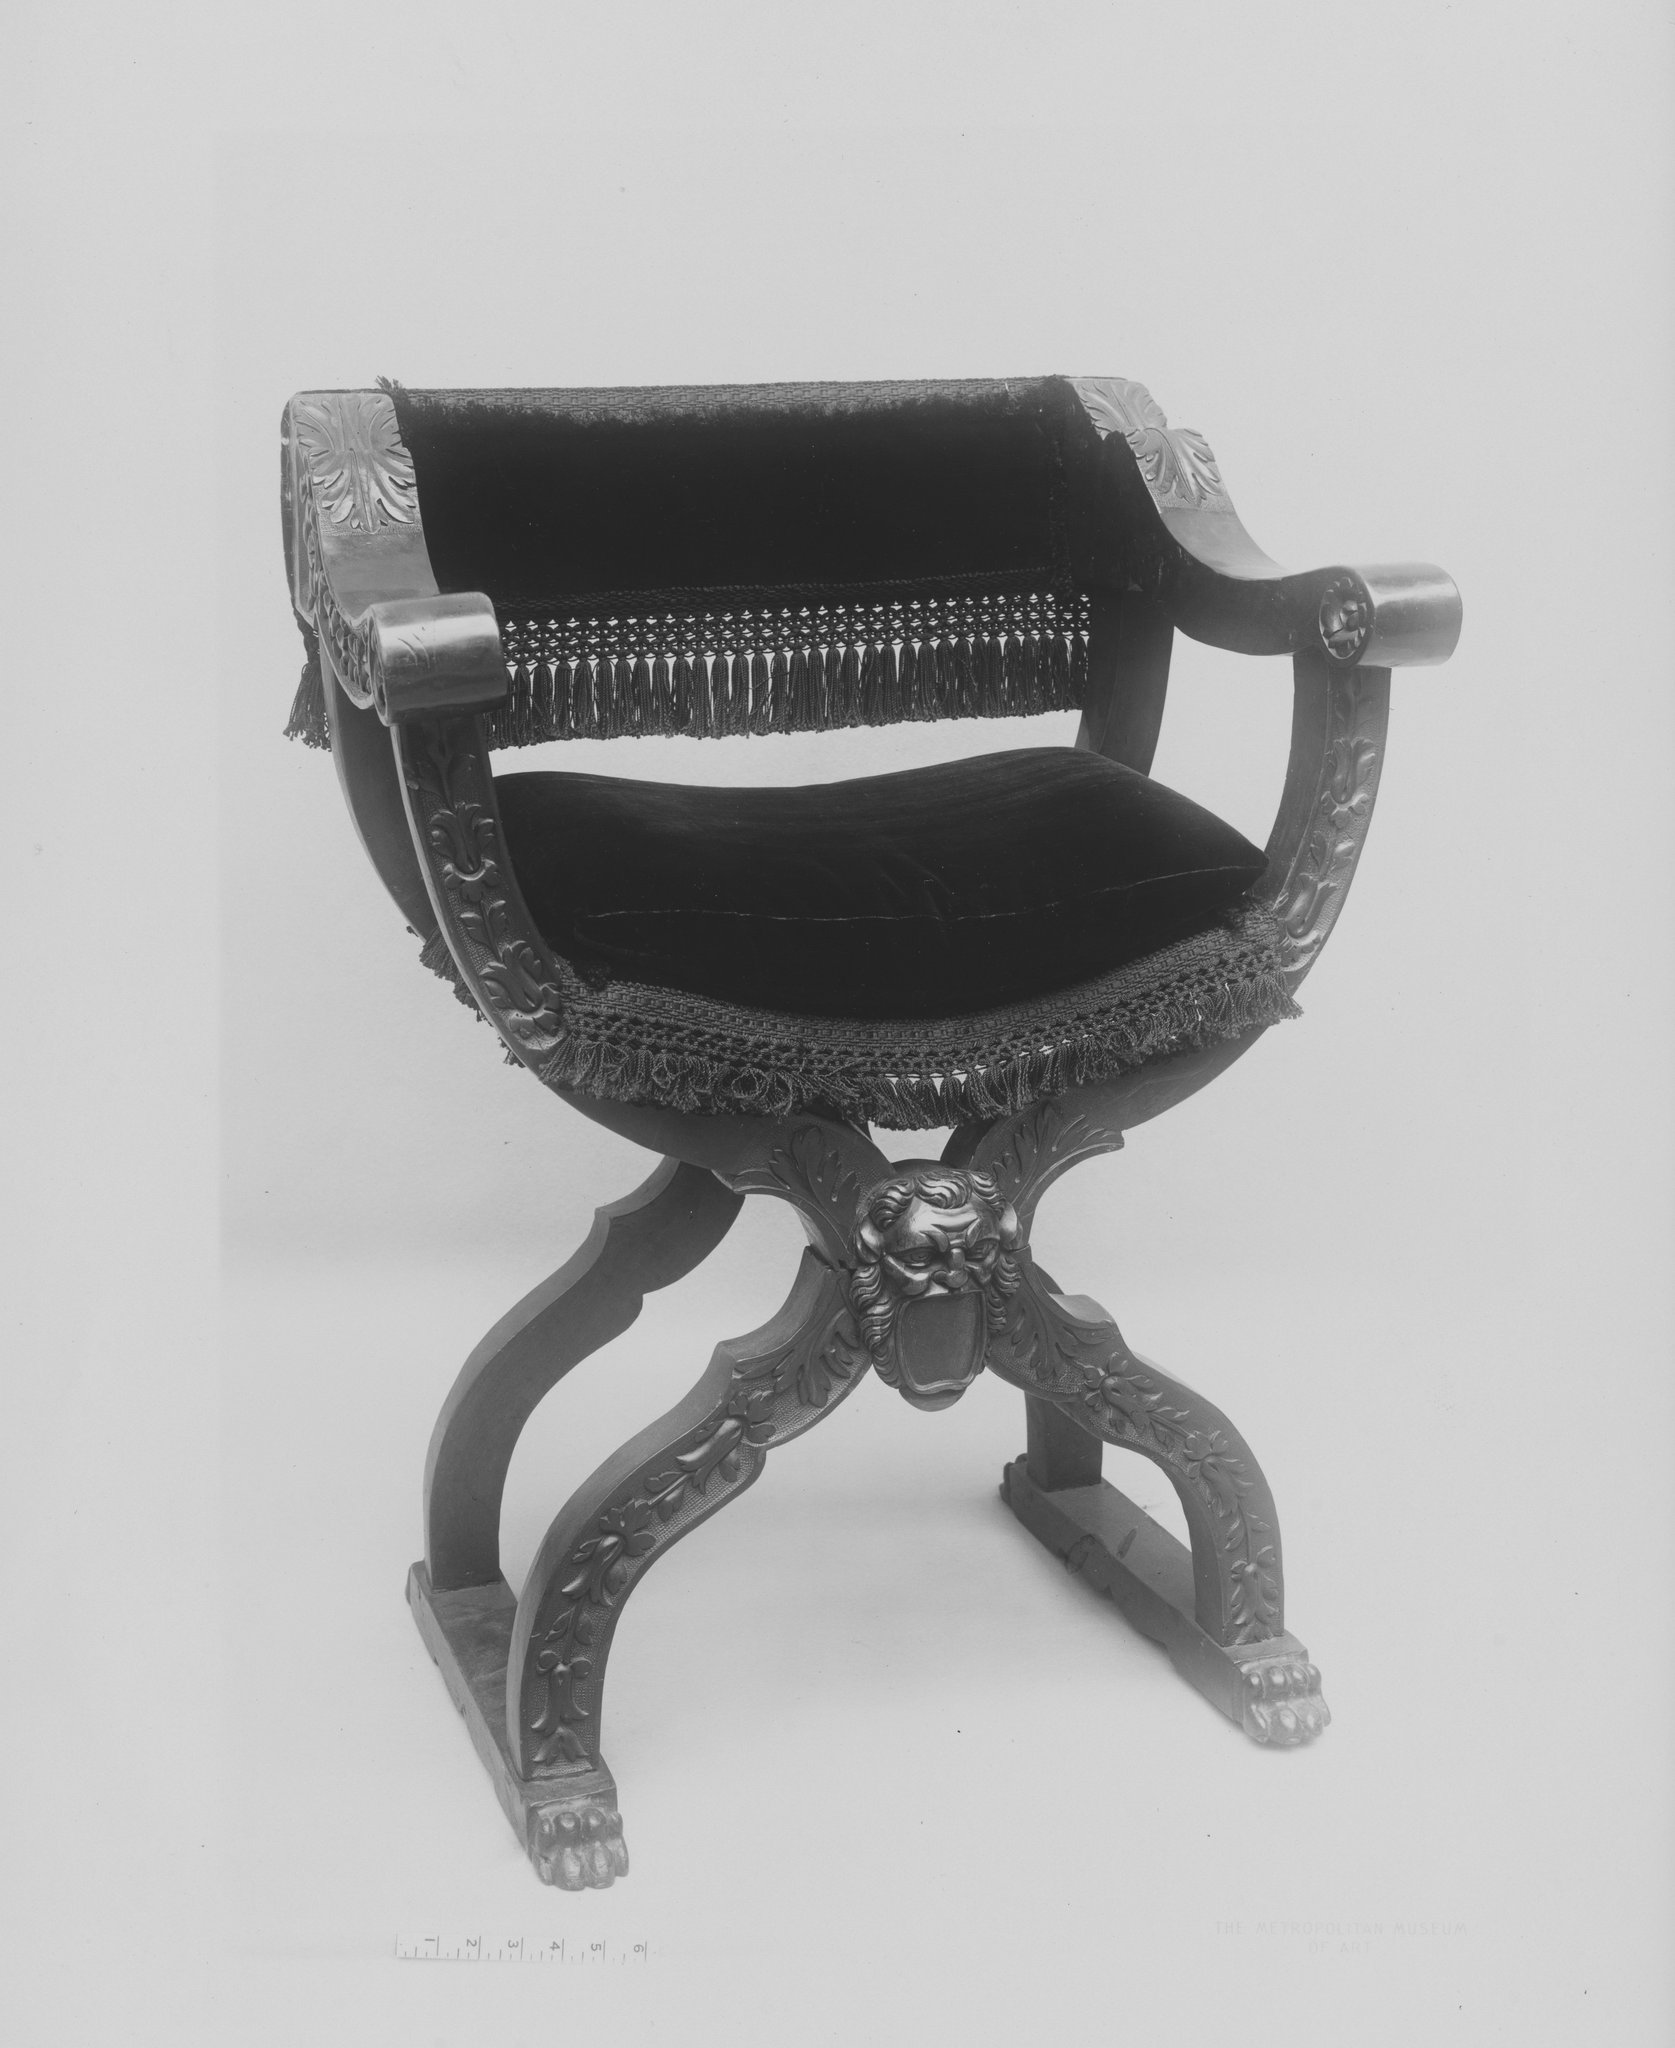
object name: armchair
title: Folding armchair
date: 1551-1600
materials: wood